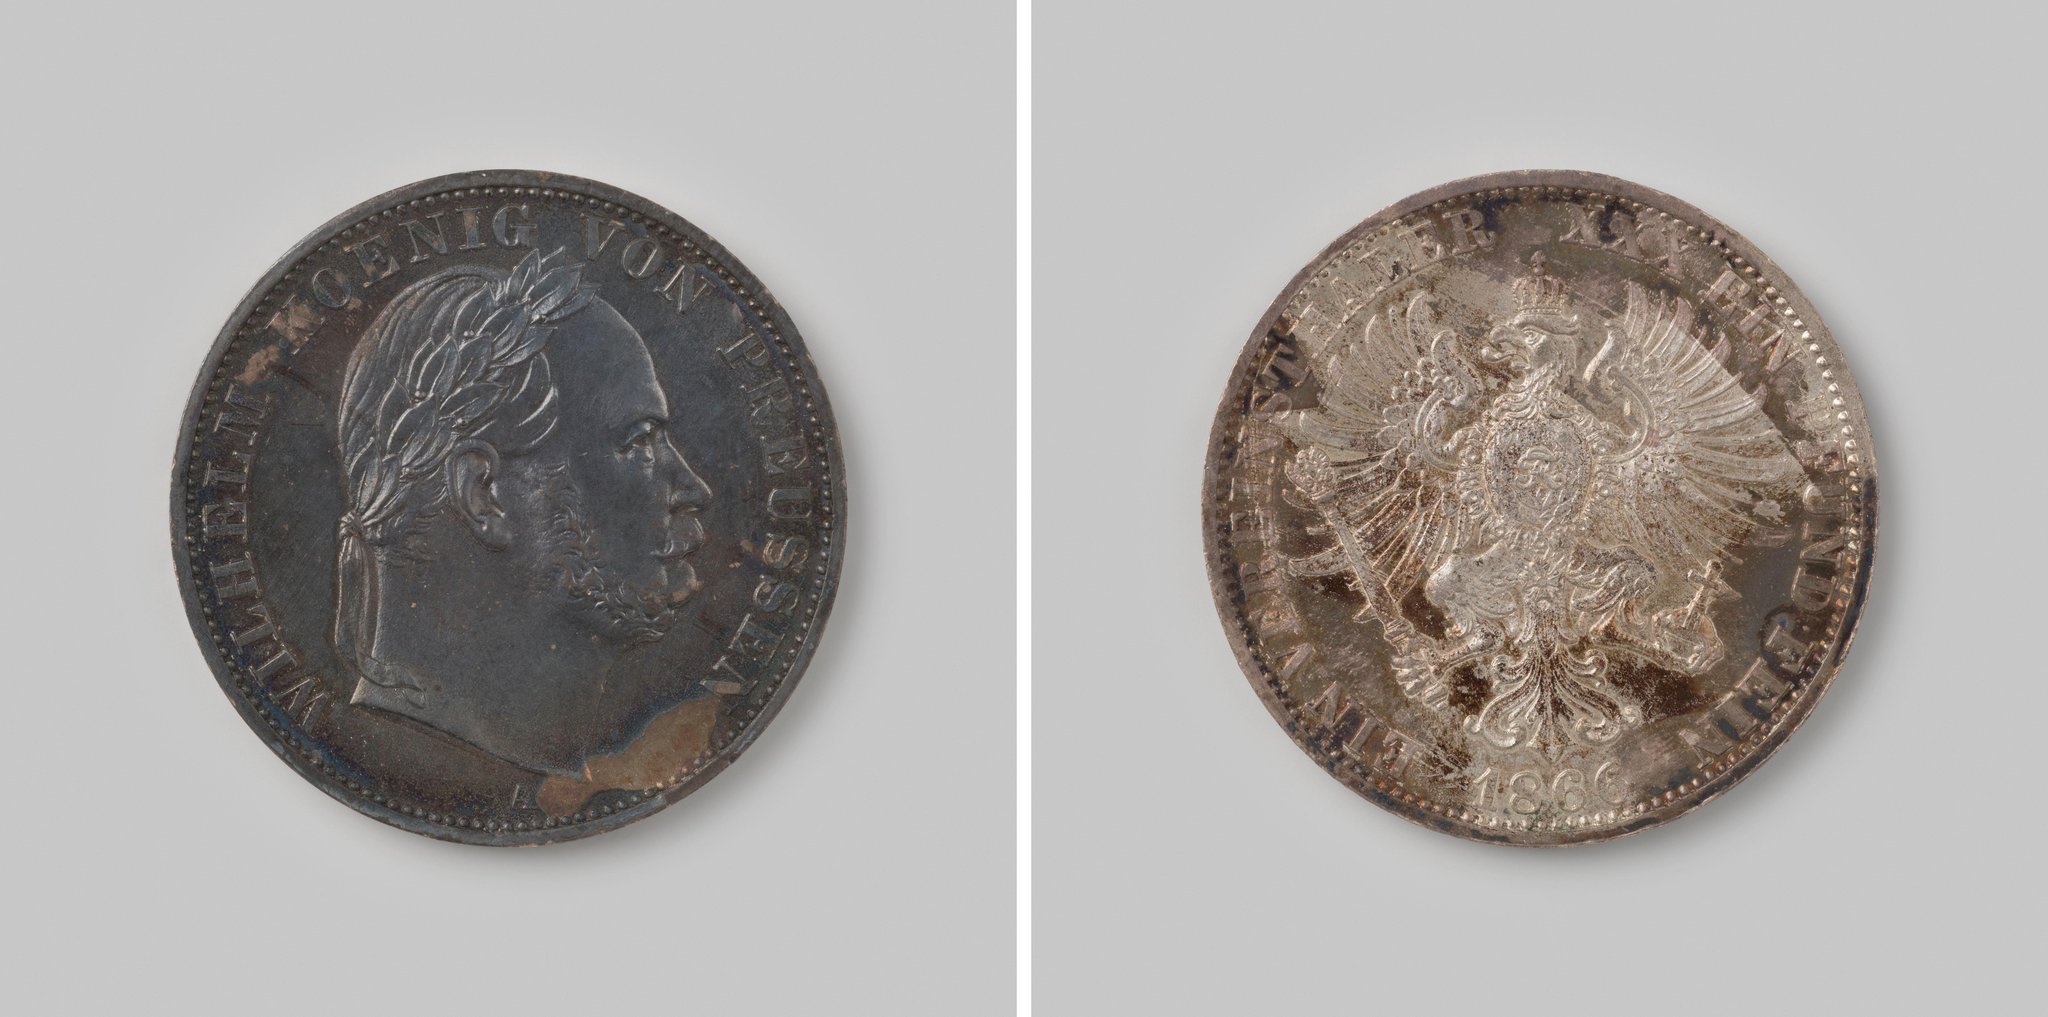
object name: siegestaler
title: Siegestaler uit Pruisen van Friedrich Wilhelm IV, 1866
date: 1866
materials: silver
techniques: striking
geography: berlin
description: Zilveren munt. Voorzijde: hoofd van de koning met lauwerkrans naar rechts. Daaronder letter A. Keerzijde: door keten en juweel van een ridderorde omhangen gekroonde enkelkoppige adelaar met in zijn poten scepter en rijksappel. Waarde-aanduiding EIN VEREINSTHALER in omschrift met jaartal onderaan. Randschrift.